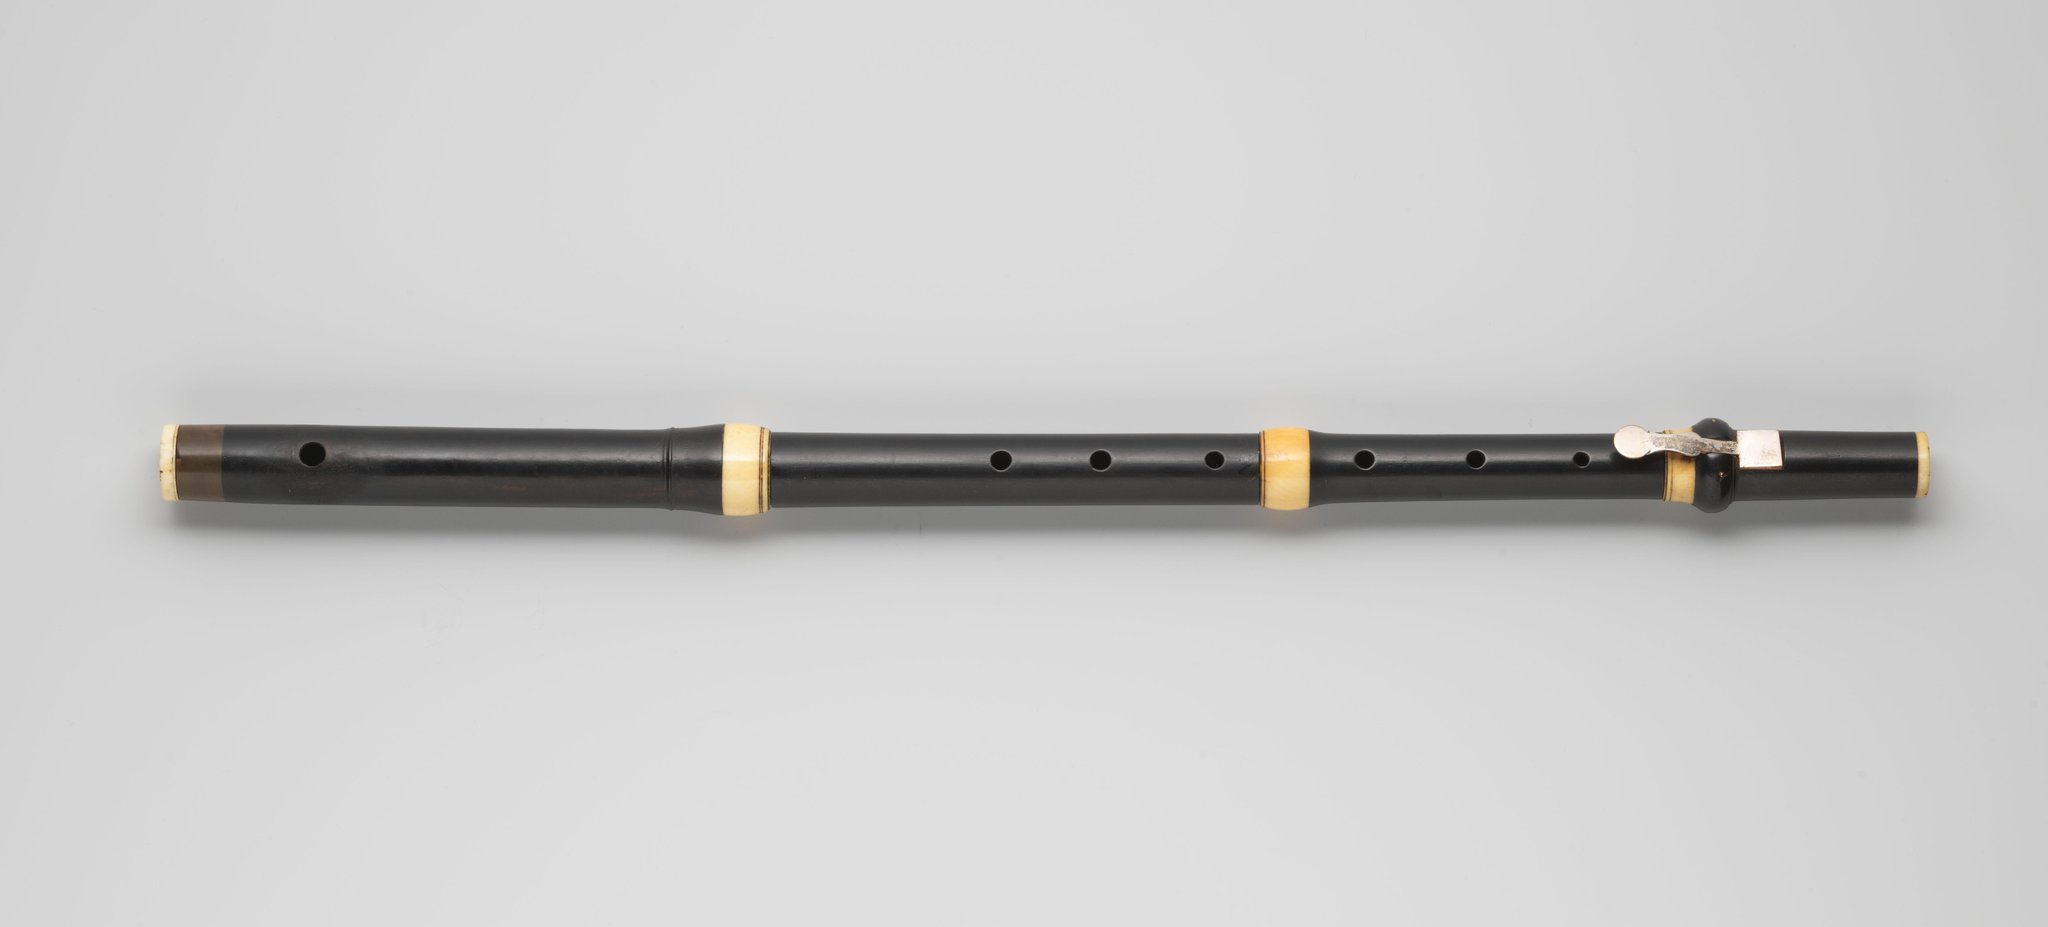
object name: wind instrument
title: Dwarsfluit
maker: Anonymous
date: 1750-1800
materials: brass, wood, ivory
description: Dwarsfluit van grenadille met drie wisselstukken, ivoren ringen en een messing klep. Stemming a=ca. 415/429 Hz.